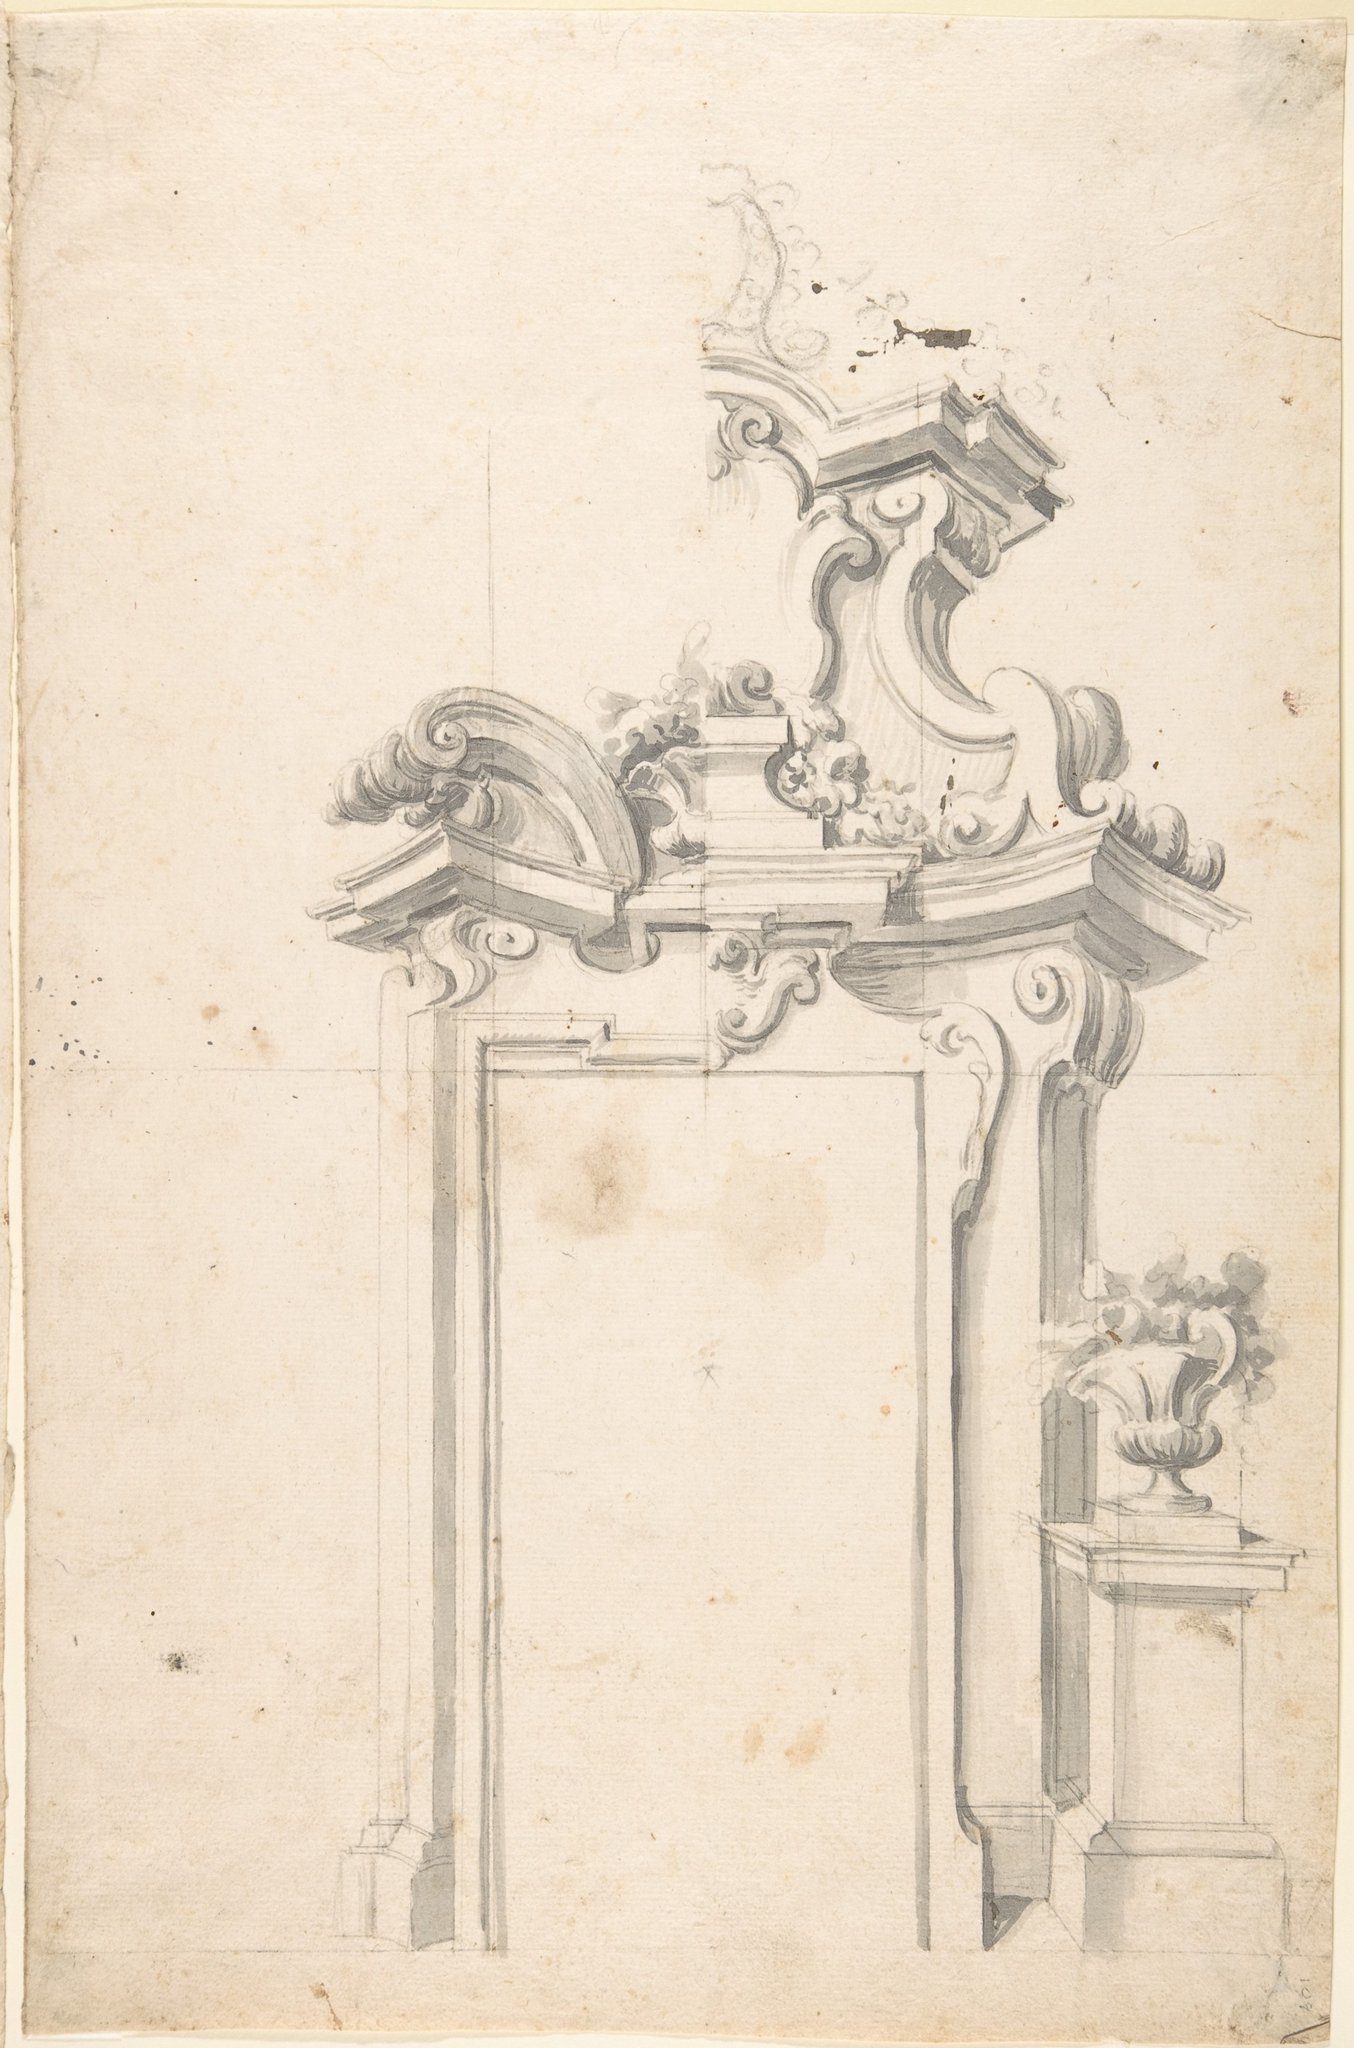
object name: drawing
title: Two Alternate Designs for a Doorway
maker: anonymous, italian, piedmontese, 18th century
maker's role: artist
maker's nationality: italian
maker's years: 1700-1800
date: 1700-1780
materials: graphite, drawing material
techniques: brush, wash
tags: doorways